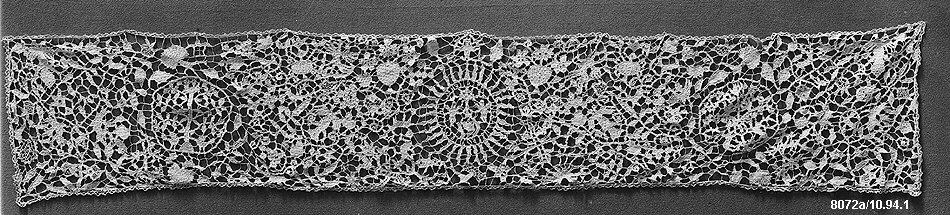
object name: altar frontal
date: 1651-1700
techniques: embroidery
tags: flowers,leaves